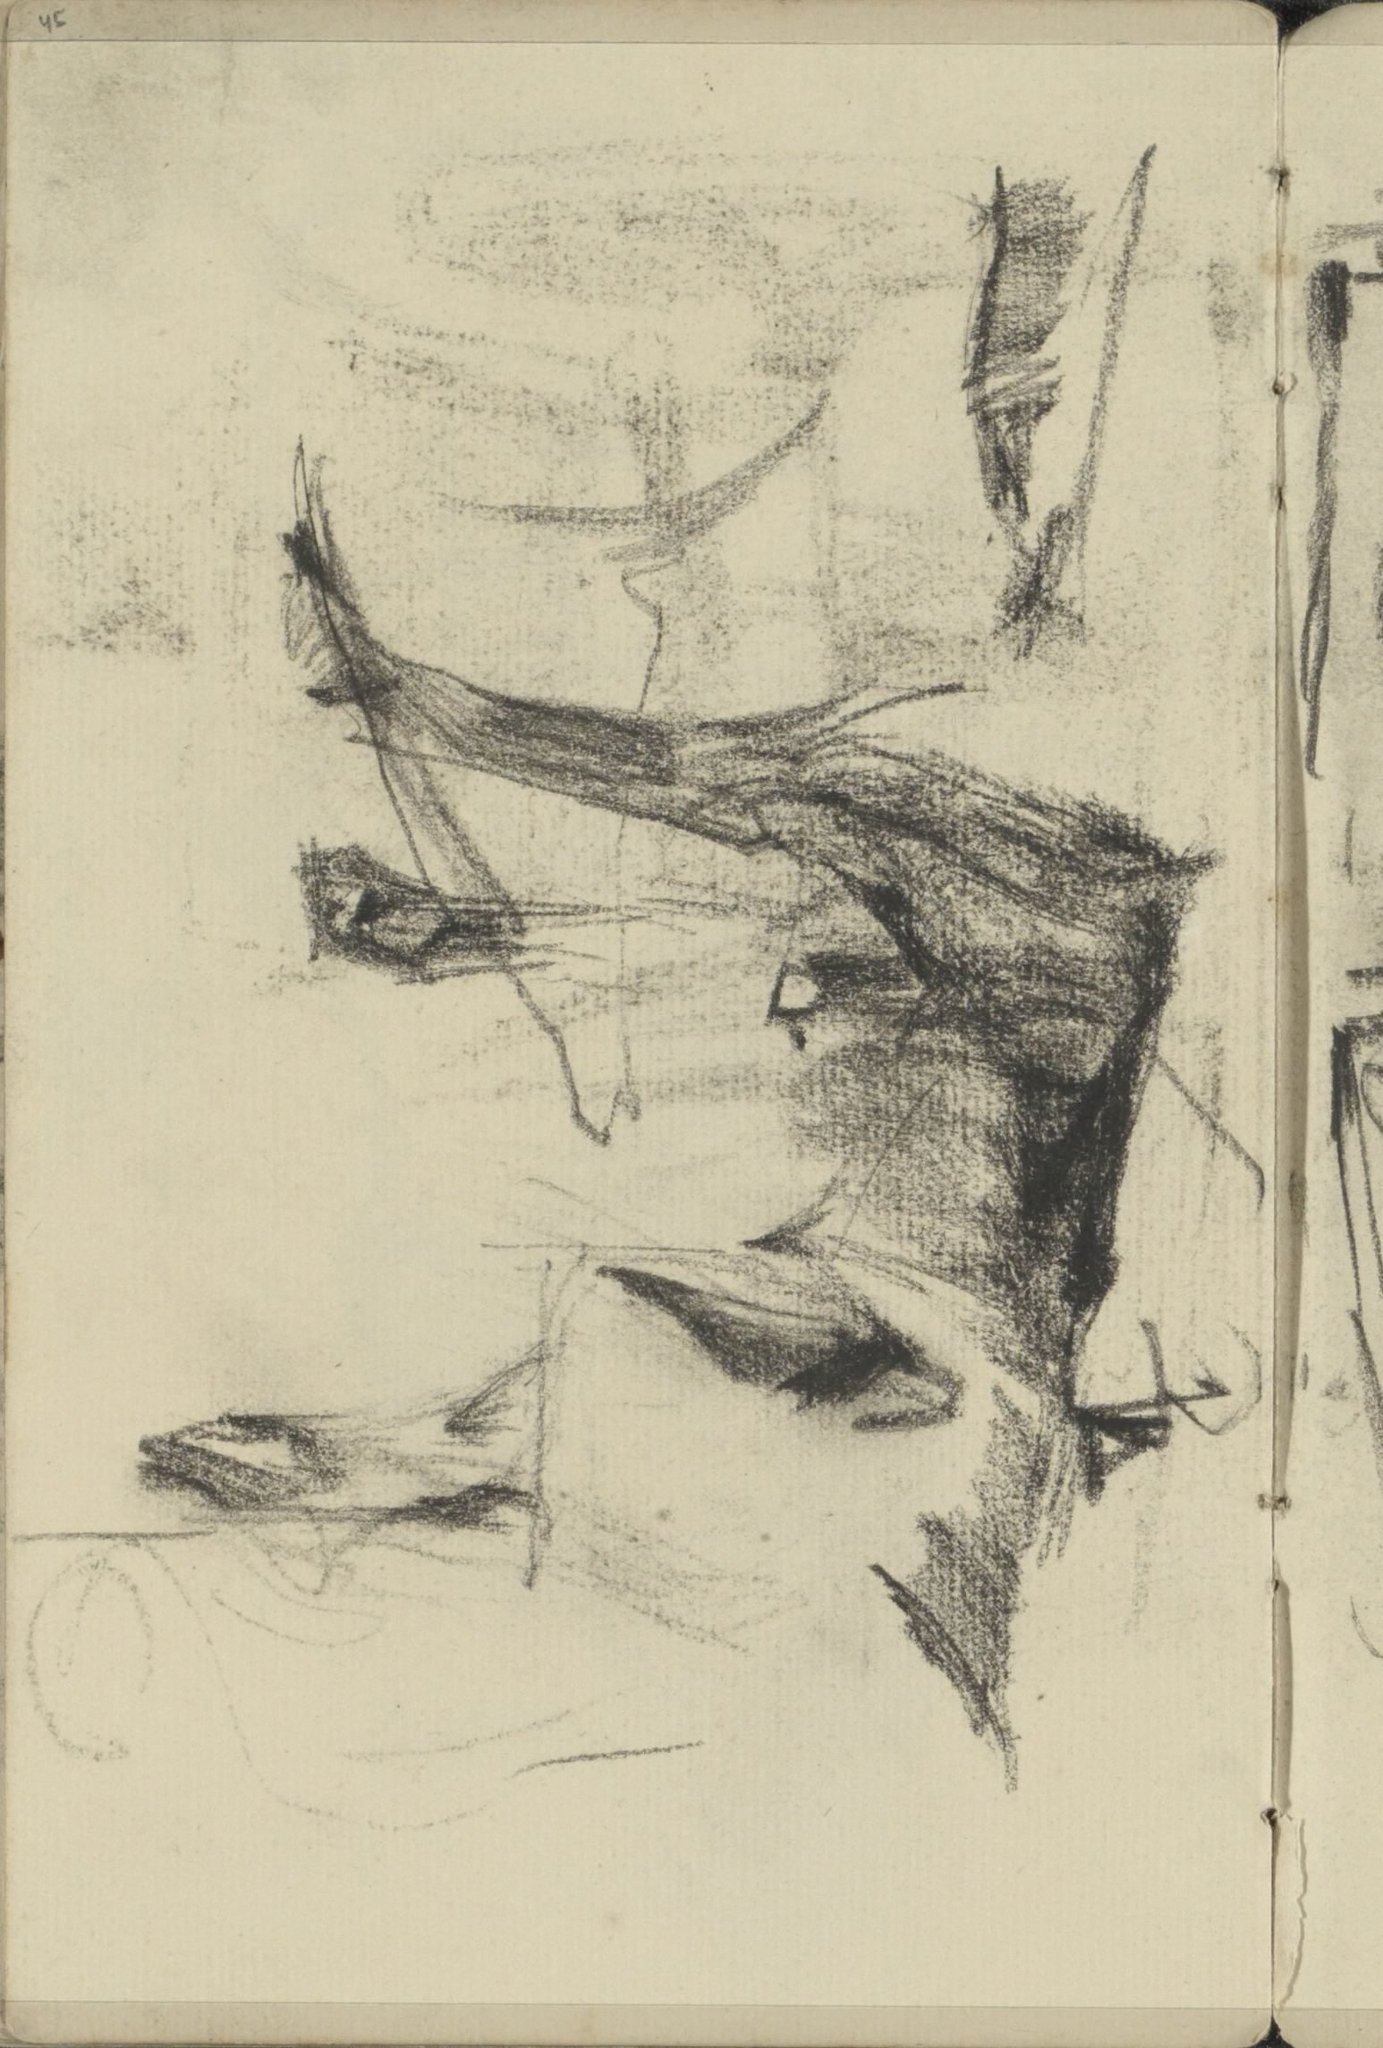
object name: sketchbook leaf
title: Paard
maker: george hendrik breitner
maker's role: draughtsman, painter, print maker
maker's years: 1857-1923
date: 1882-1884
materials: chalk, paper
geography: the hague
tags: horse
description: Pagina 45 uit een schetsboek met 24 bladen.